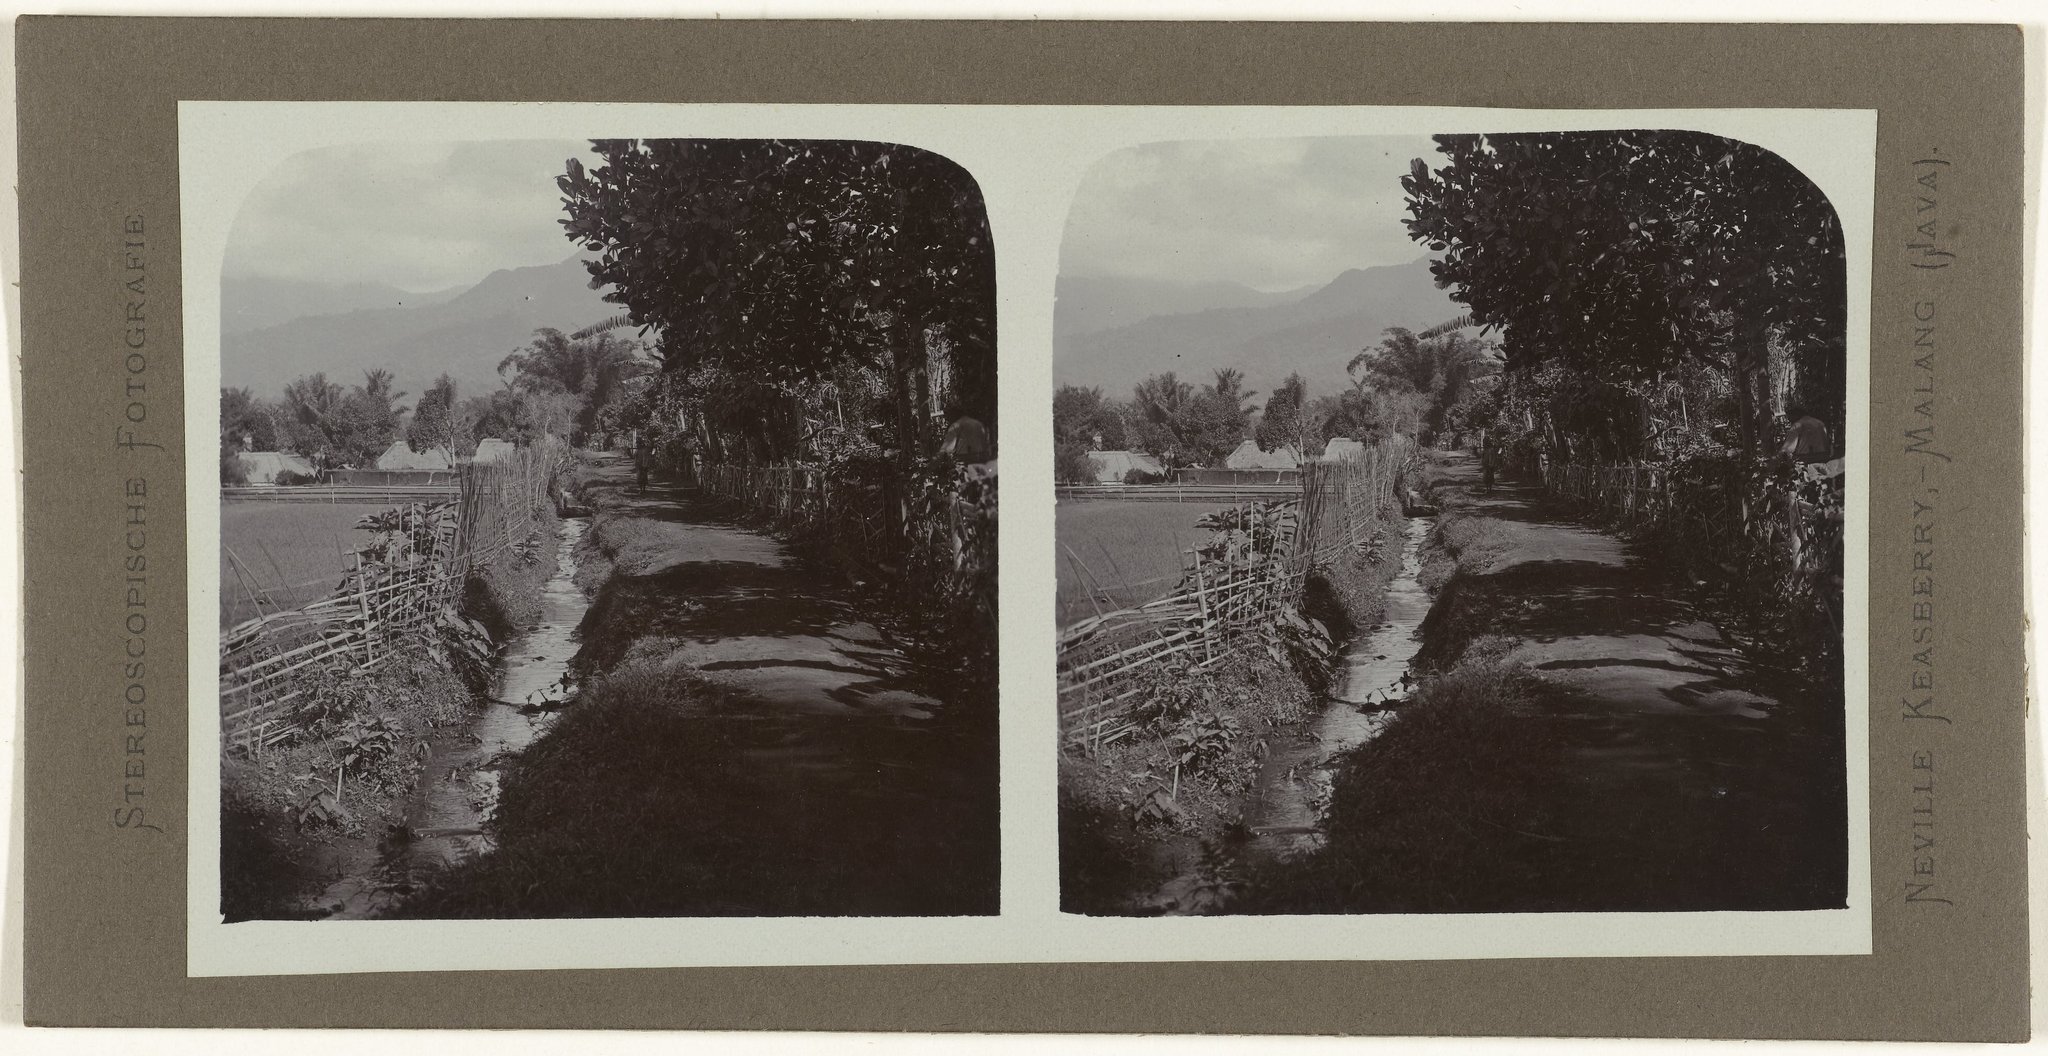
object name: stereograph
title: Straatgezicht op Java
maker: neville keasberry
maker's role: fotograaf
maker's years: 1866-1944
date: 1900-1935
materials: cardboard, paper, photographic support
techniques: albumen print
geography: malang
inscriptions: title: ‘S 3 No 35. Een dessa weg.’, signature: ‘Neville Keasberry, Malang (Java)’, inscription: ‘Stereoscopische Fotografie’